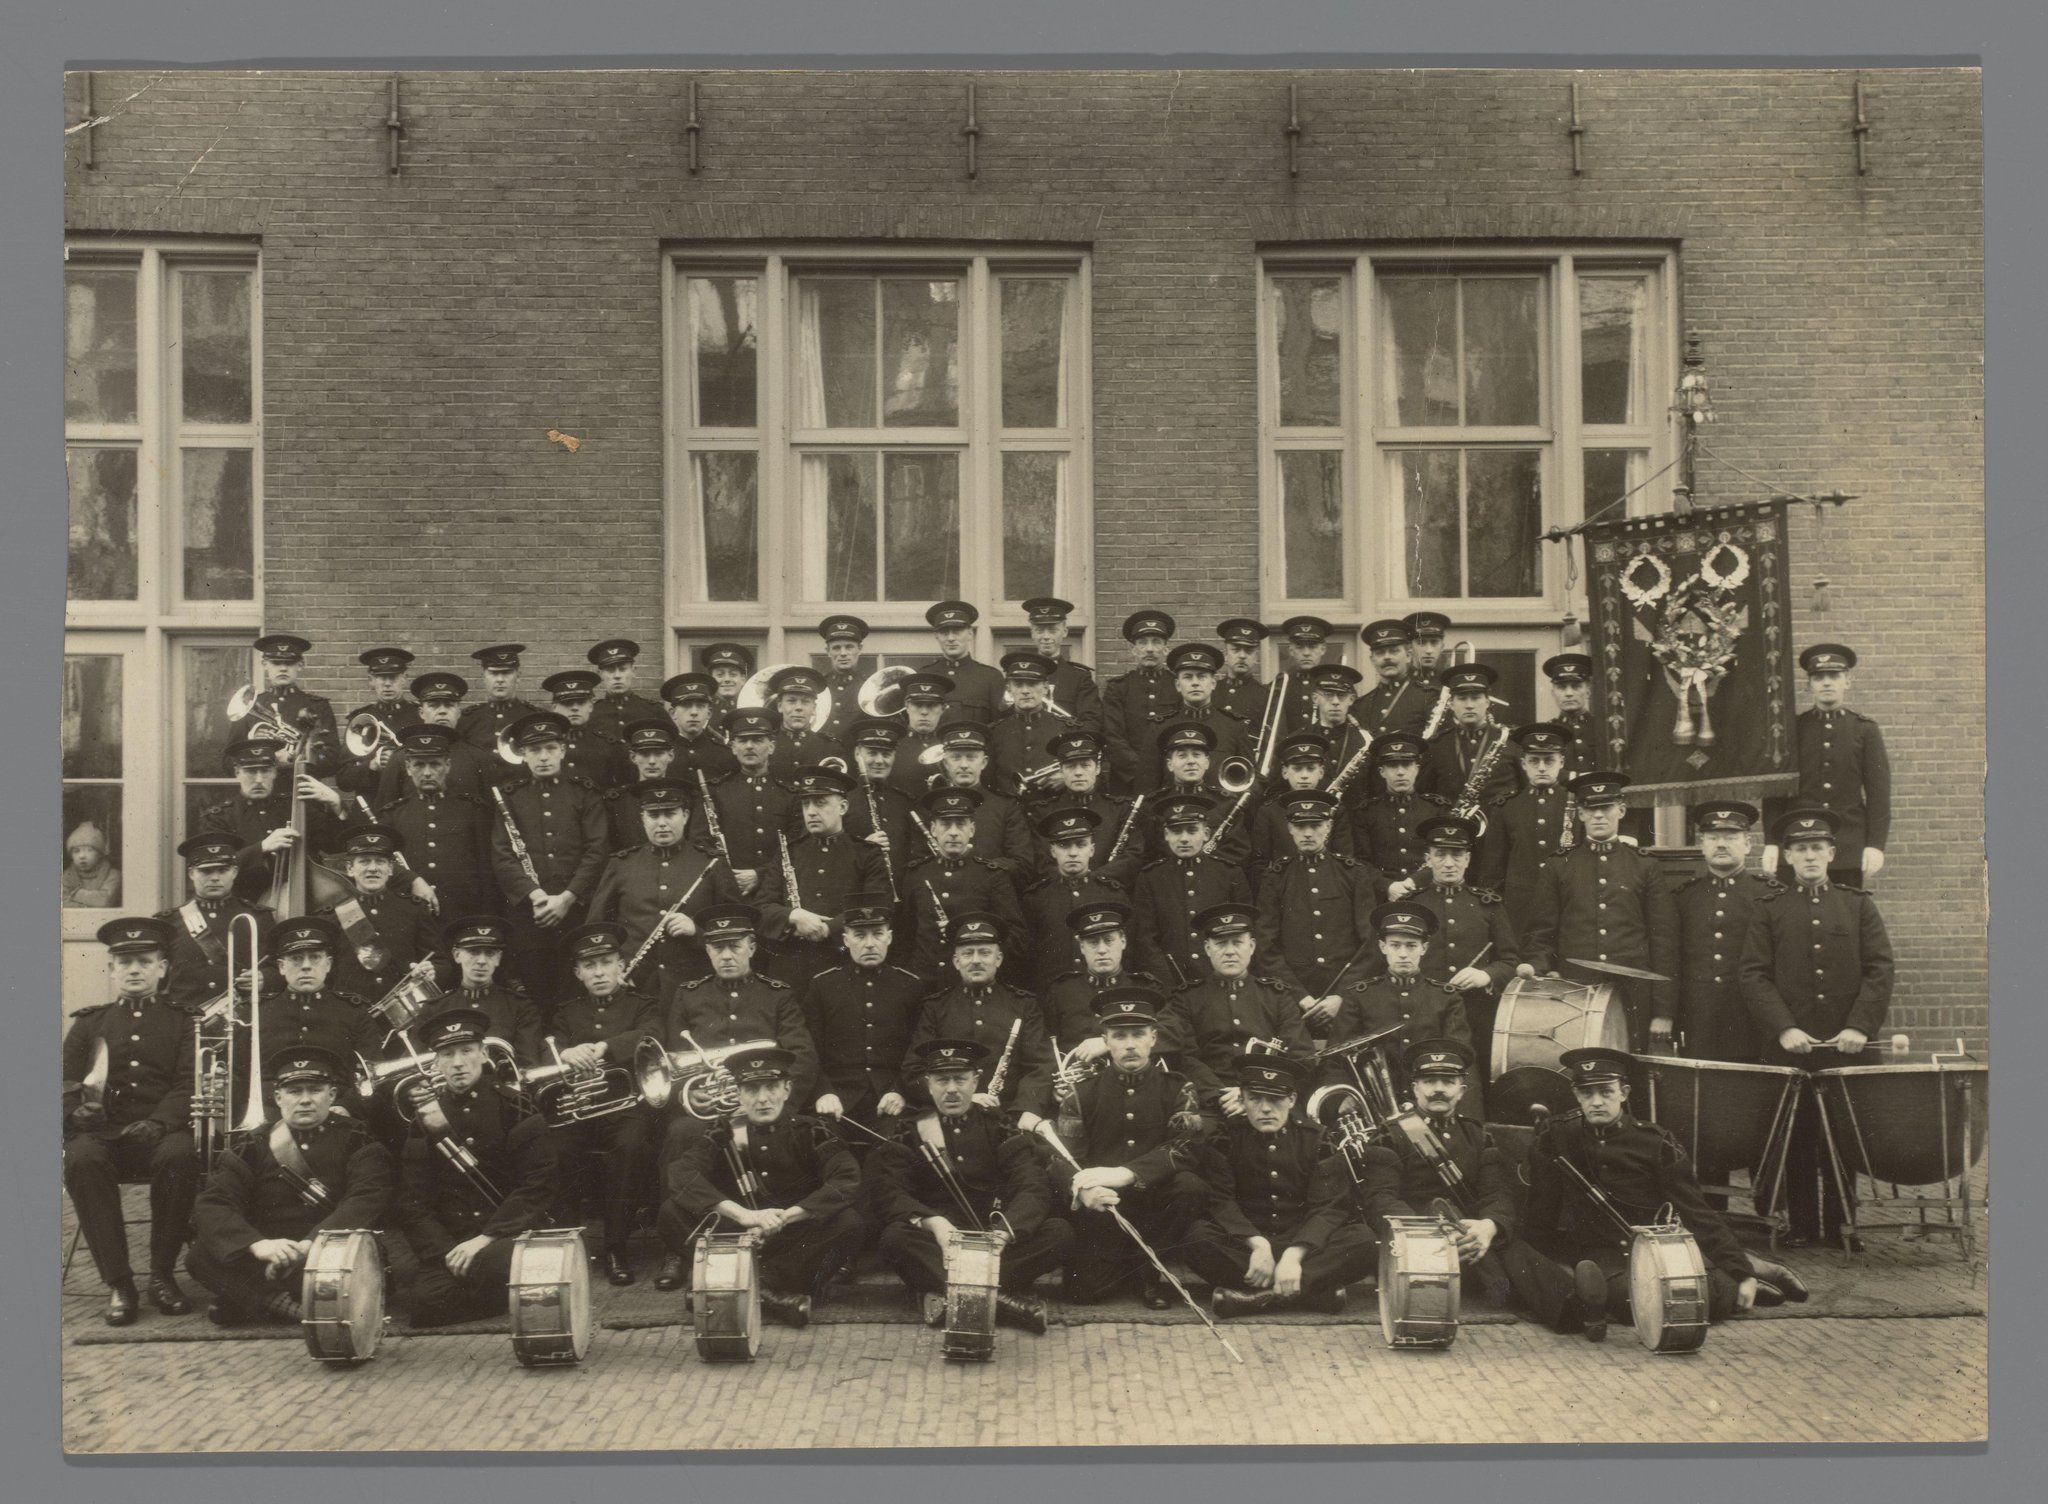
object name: photograph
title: Groepsportret van de Amsterdamsche Postharmonie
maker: Anonymous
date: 1930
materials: cardboard, photographic support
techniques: gelatin silver print